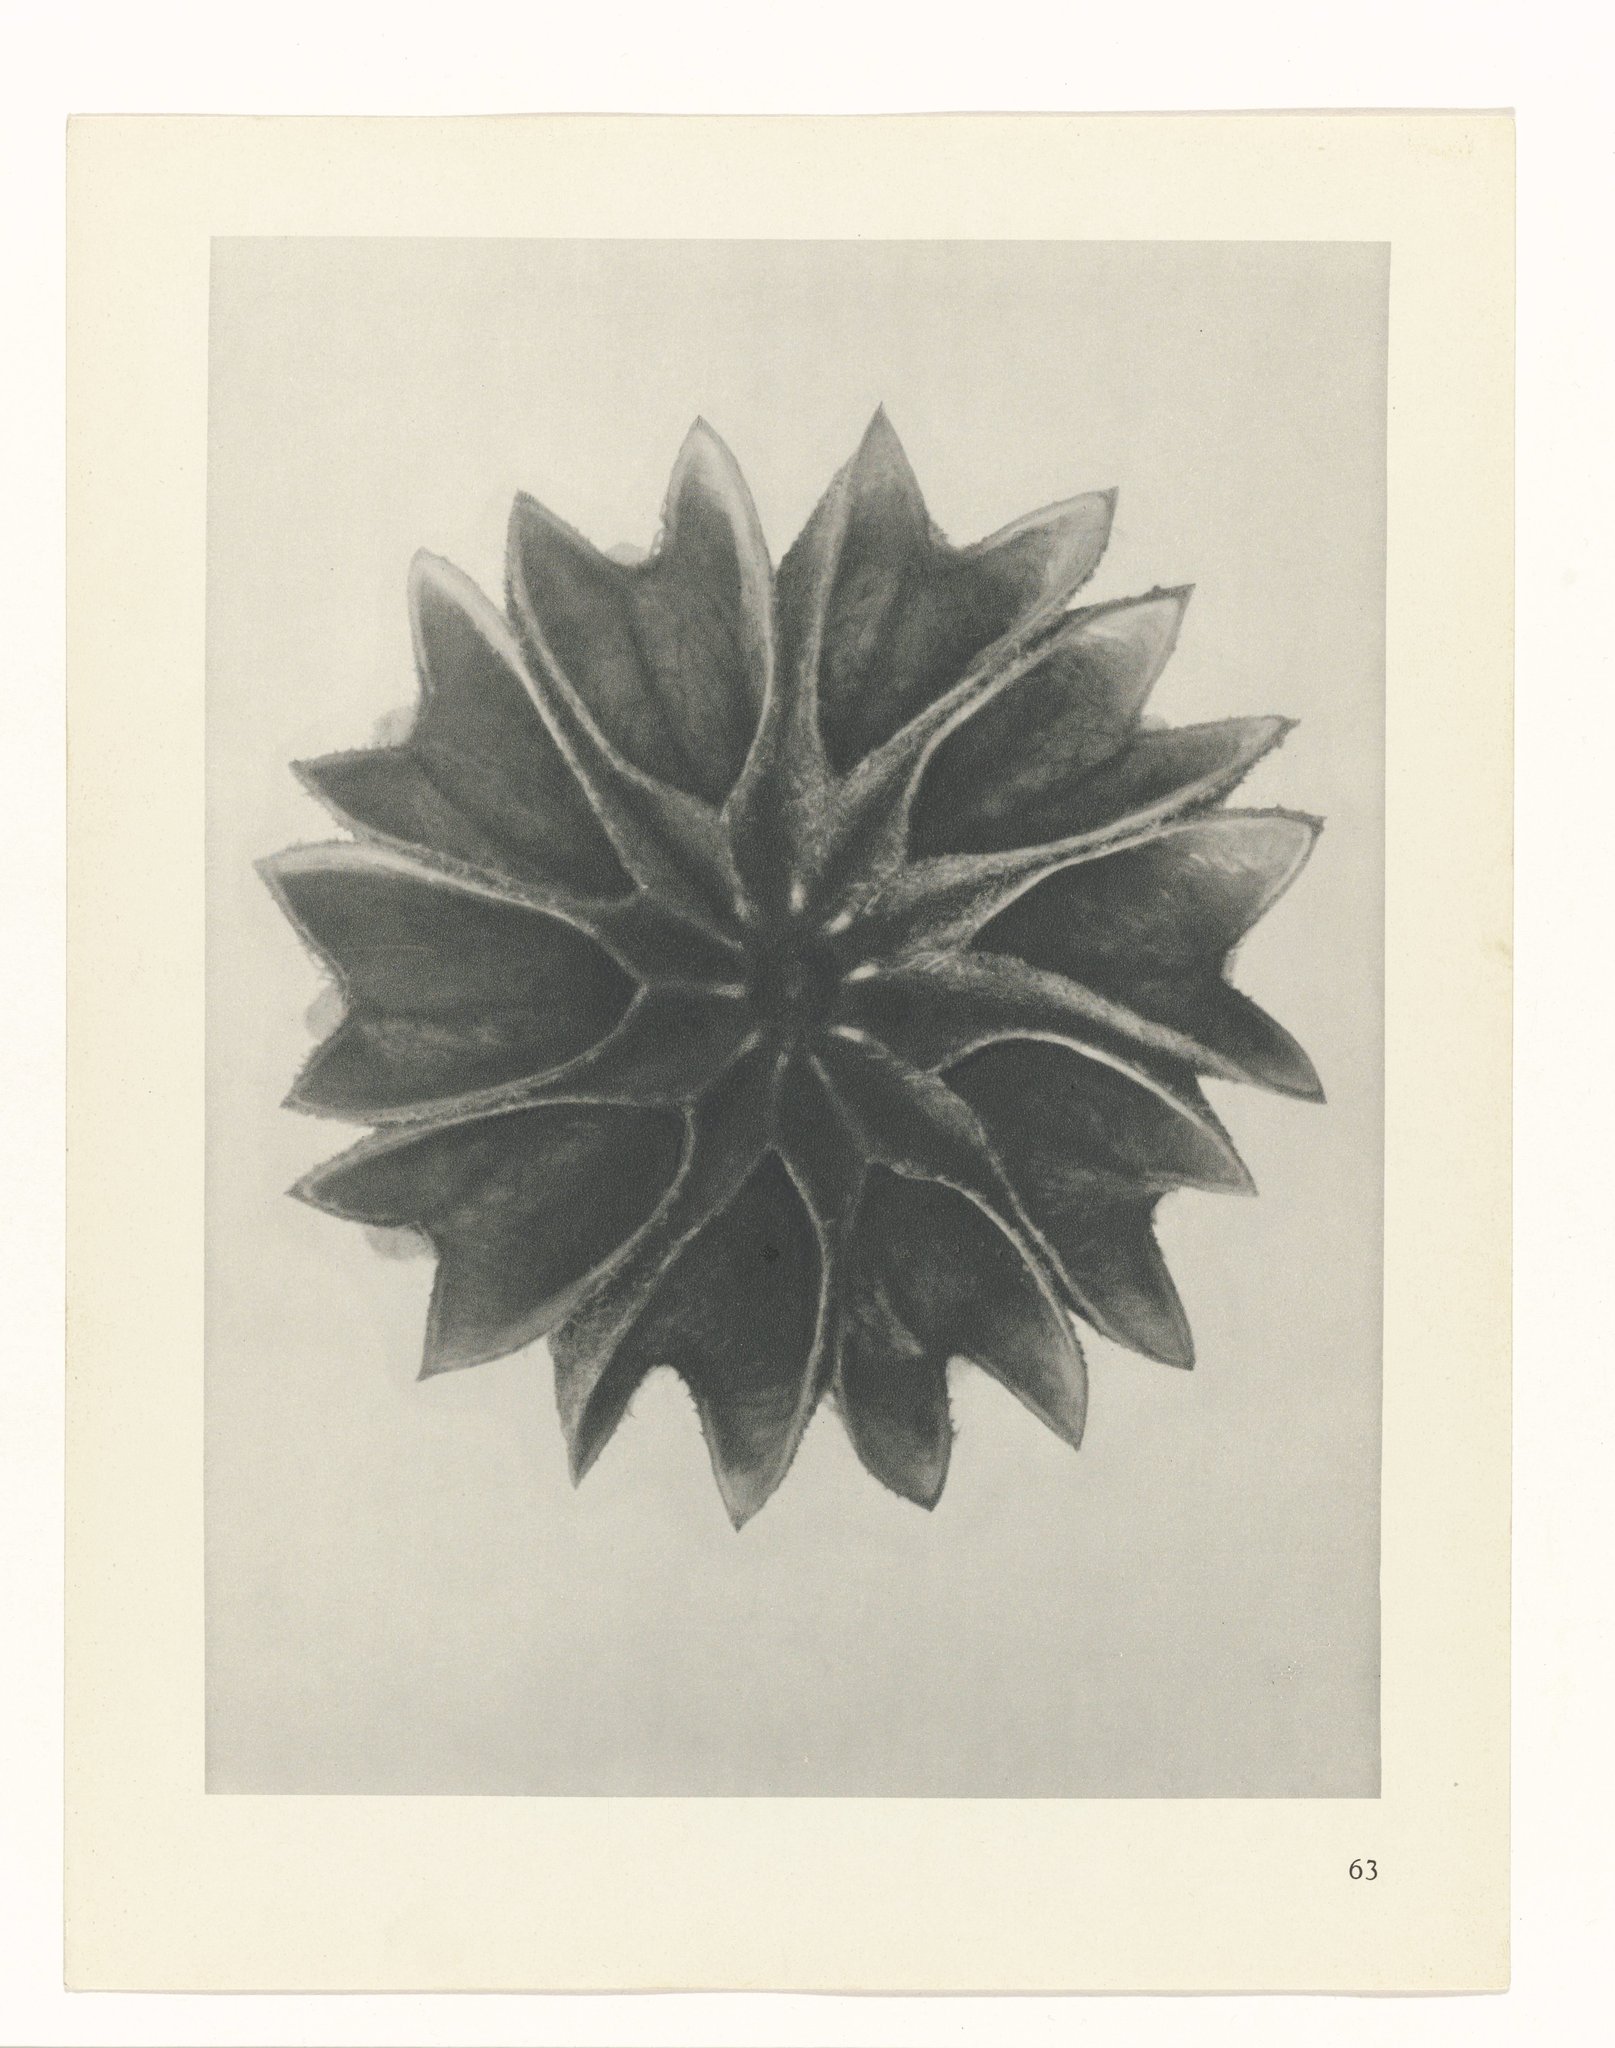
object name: photograph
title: Plantstudie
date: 1928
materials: ink, paper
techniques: rotogravure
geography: berlin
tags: plants (in general)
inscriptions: number: ‘63’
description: facher Vergrößerung. Afkomstig uit losbladige uitgave.